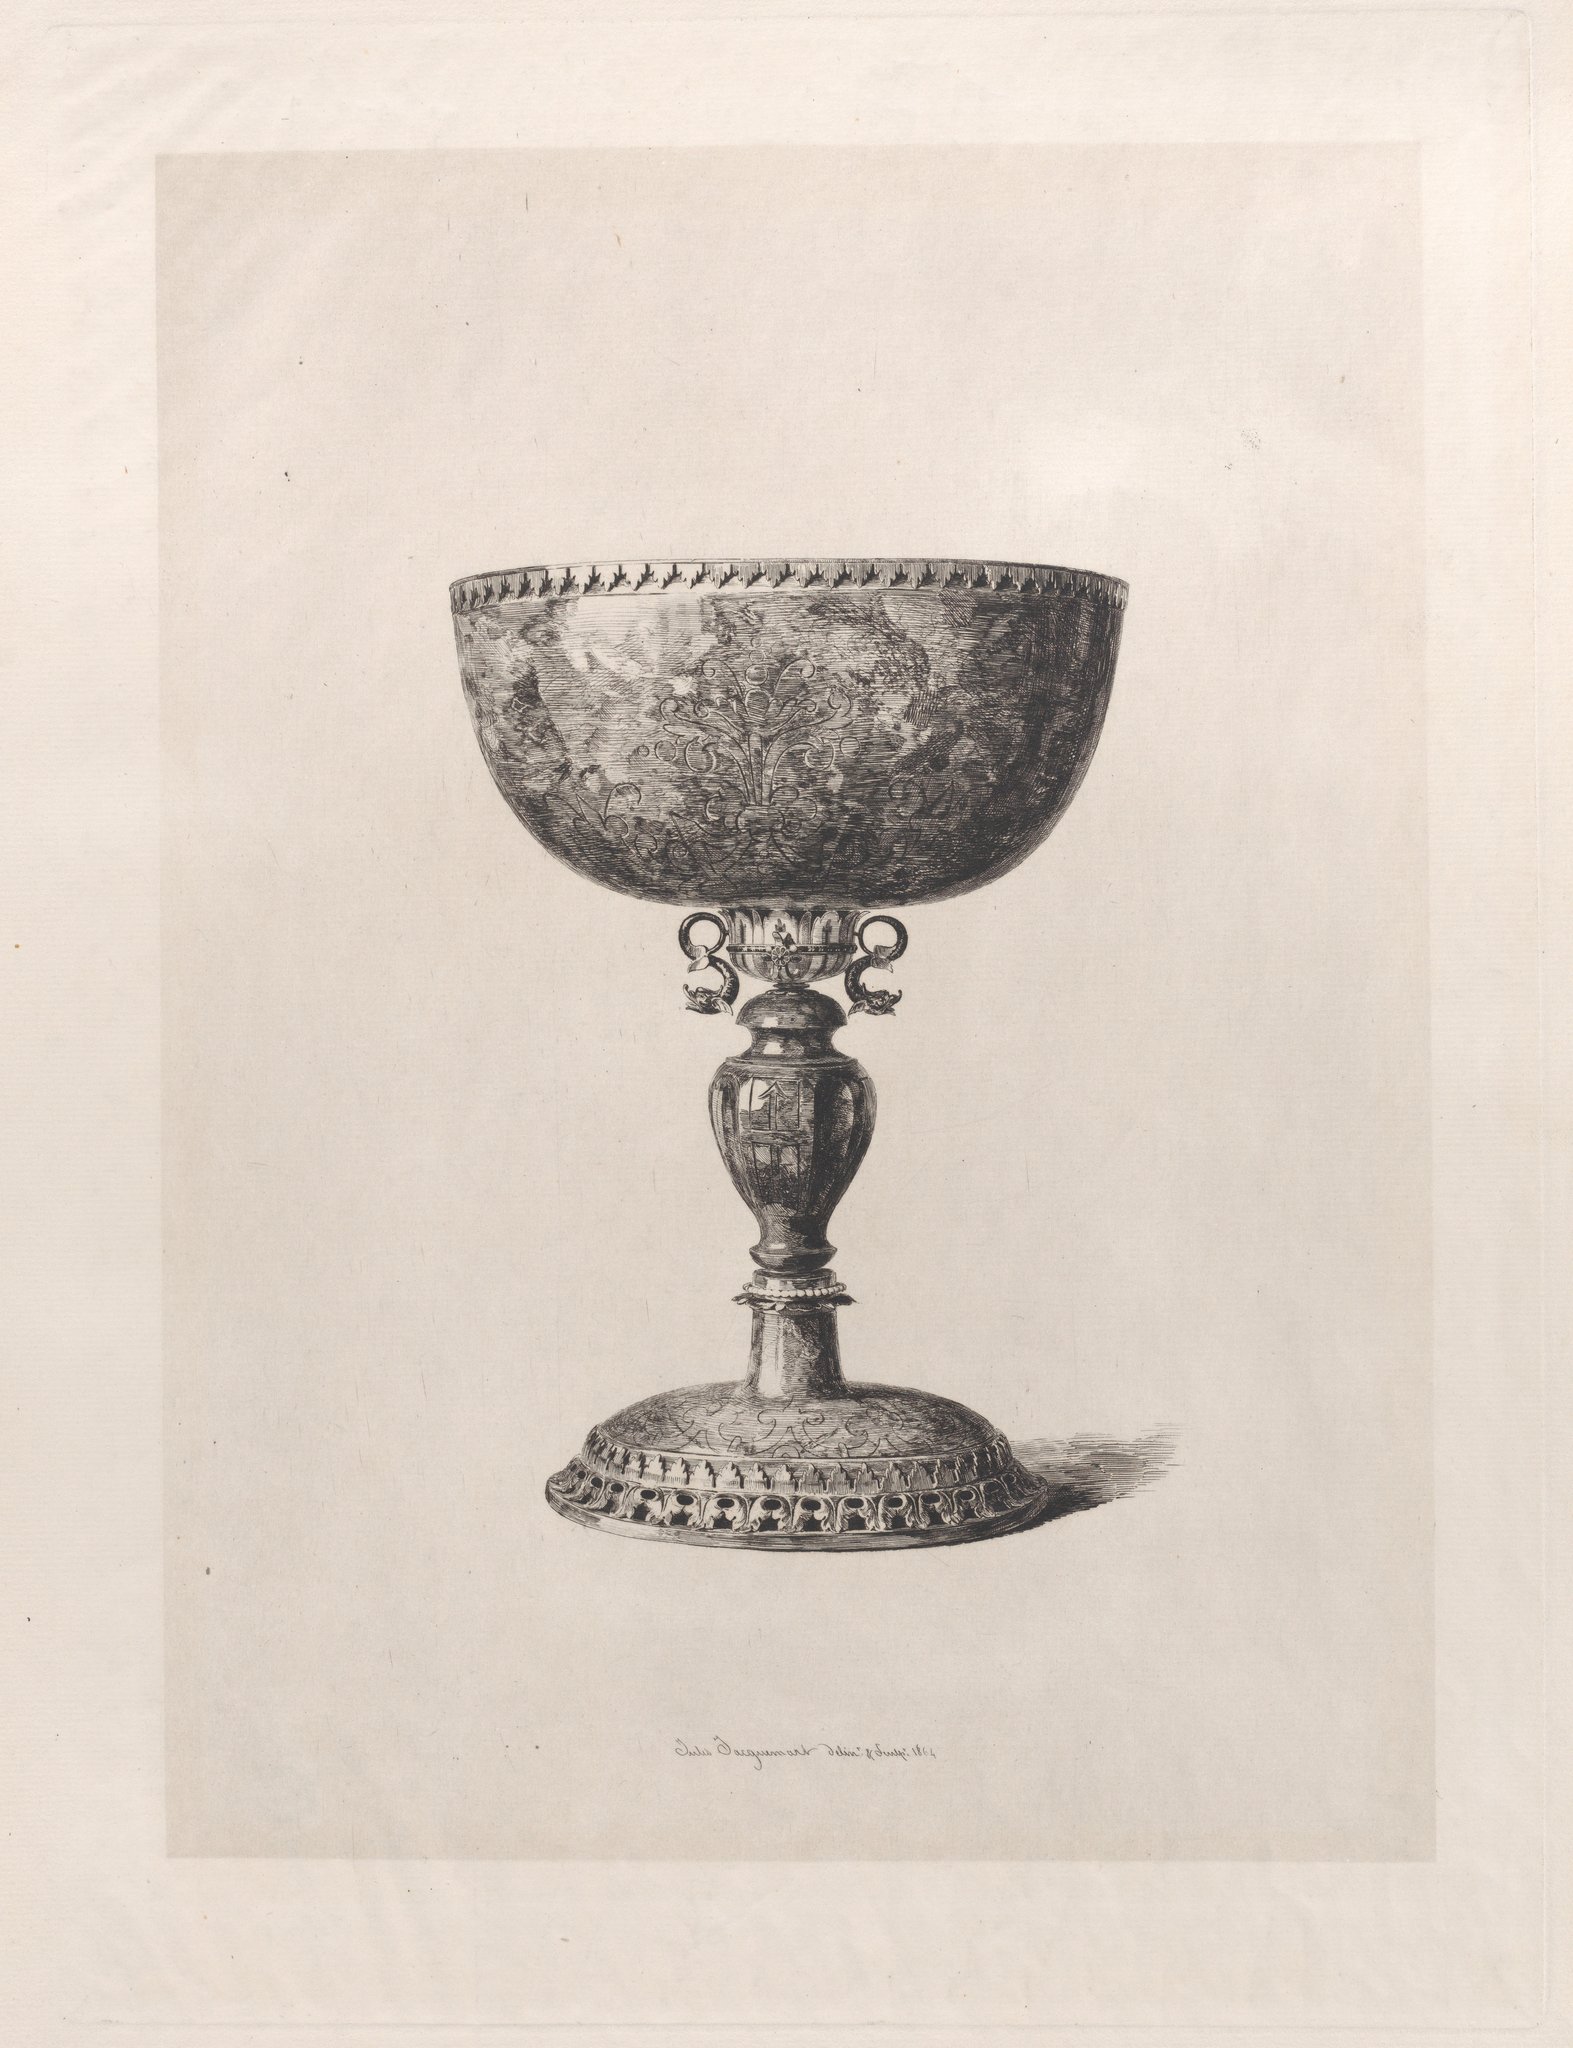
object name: print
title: Sicilian Jasper Cup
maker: jules-ferdinand jacquemart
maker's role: artist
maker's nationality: french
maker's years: 1837-1880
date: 1864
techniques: etching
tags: cups